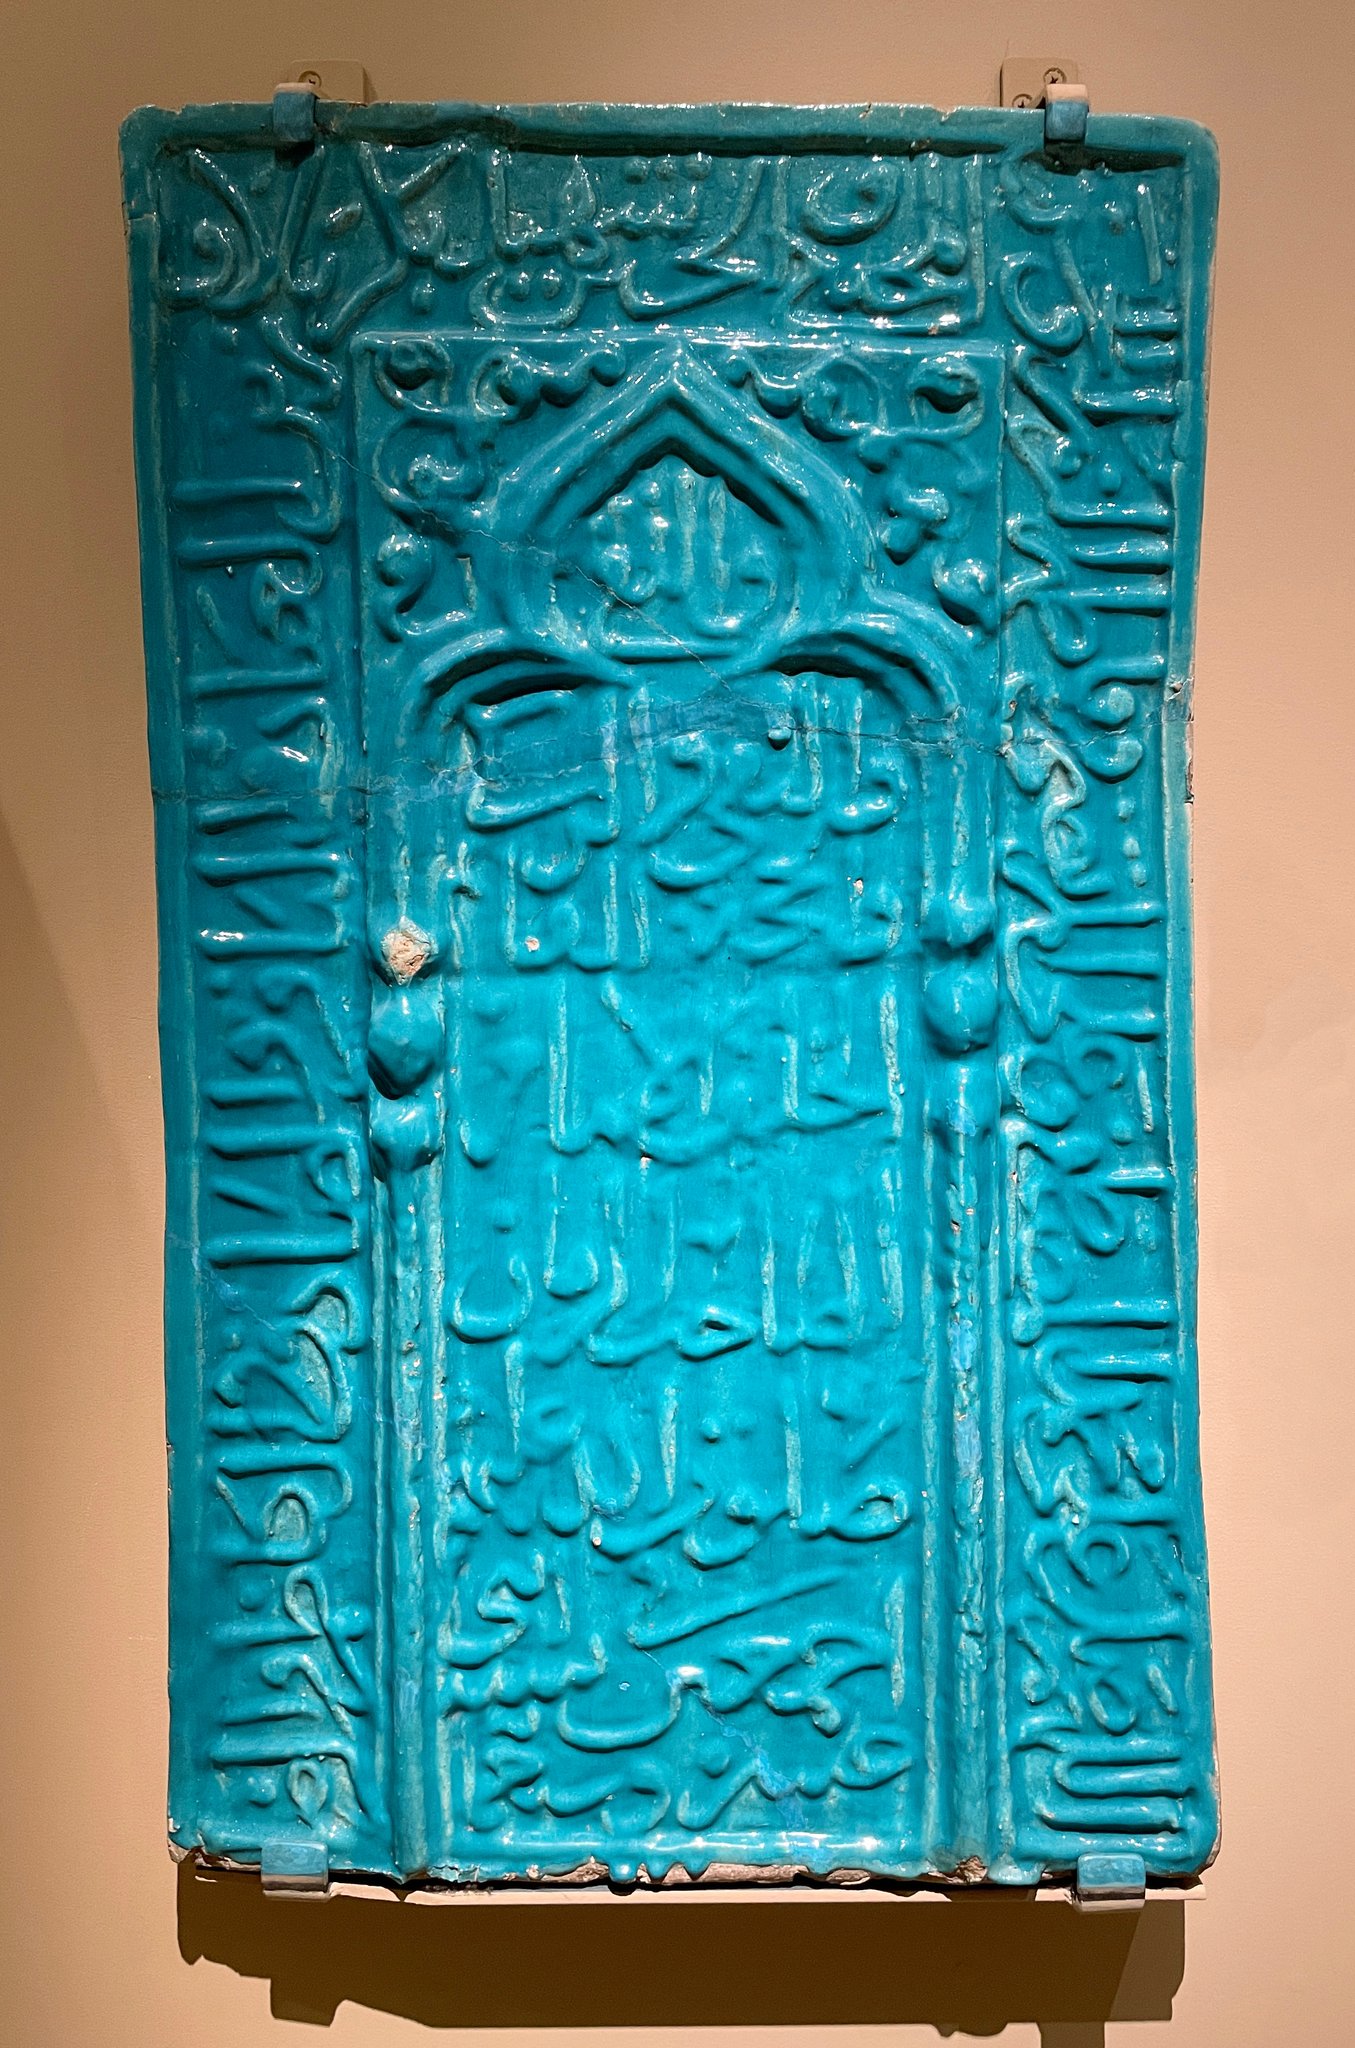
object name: tile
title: Tile with Niche Design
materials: stonepaste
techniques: glazing, molding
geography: iran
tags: mihrabs